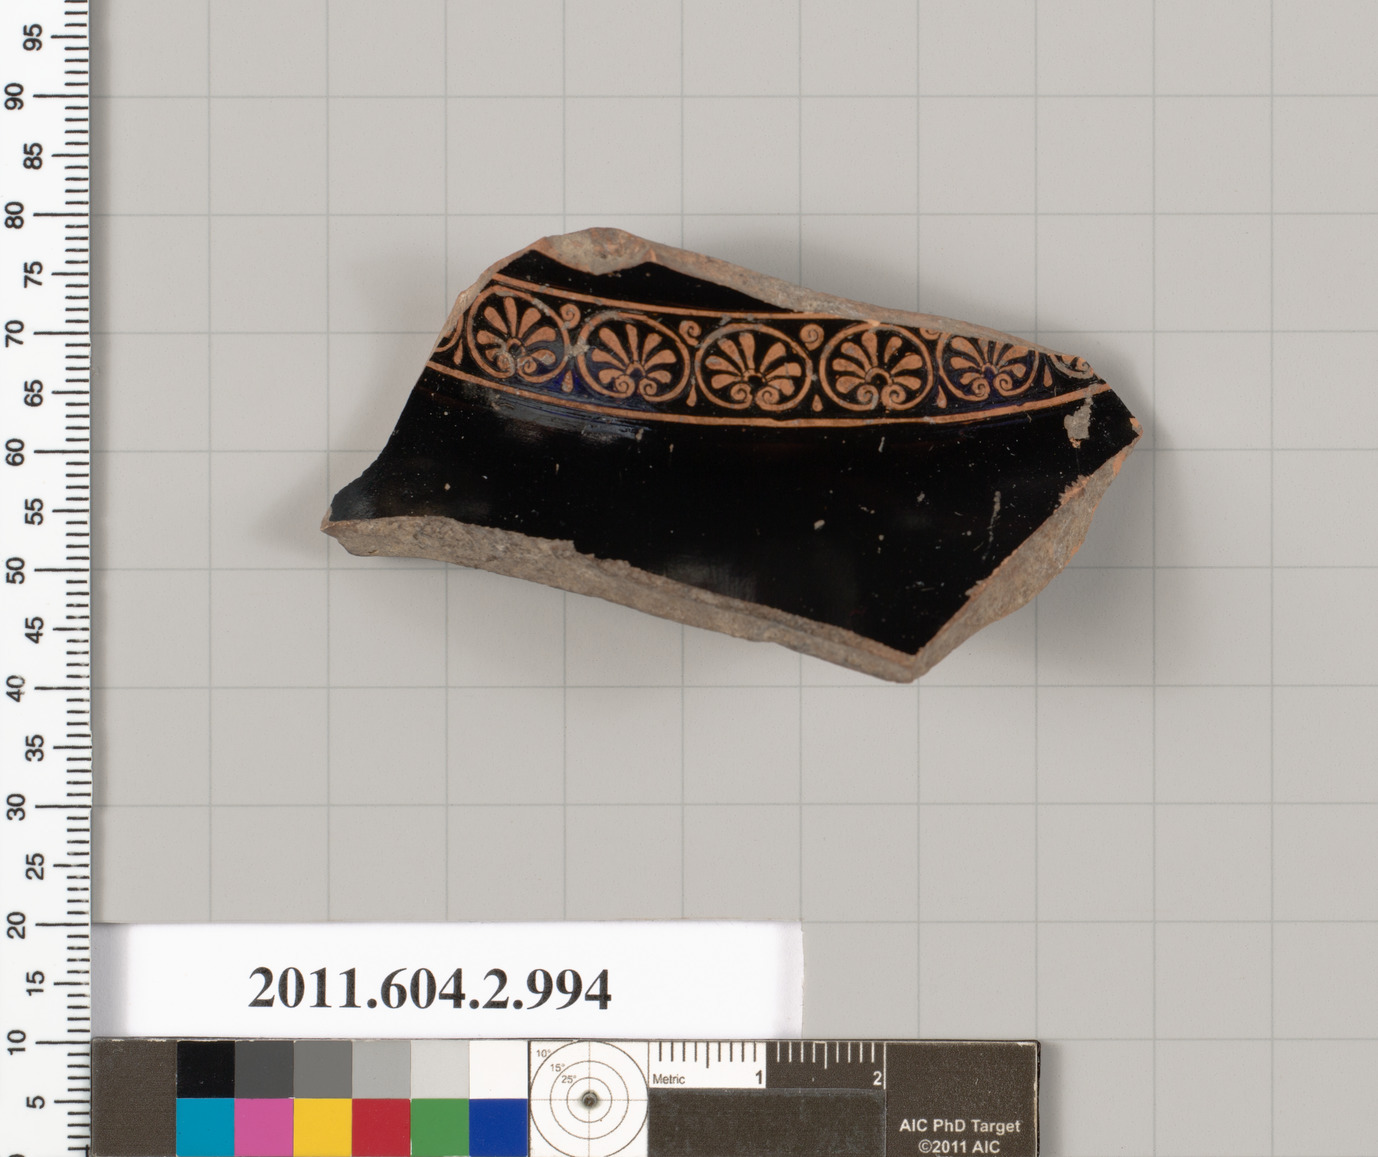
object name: chou fragment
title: Terracotta fragment of an oinochoe: chous (jug)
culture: greek, attic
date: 460-440 BCE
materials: terracotta